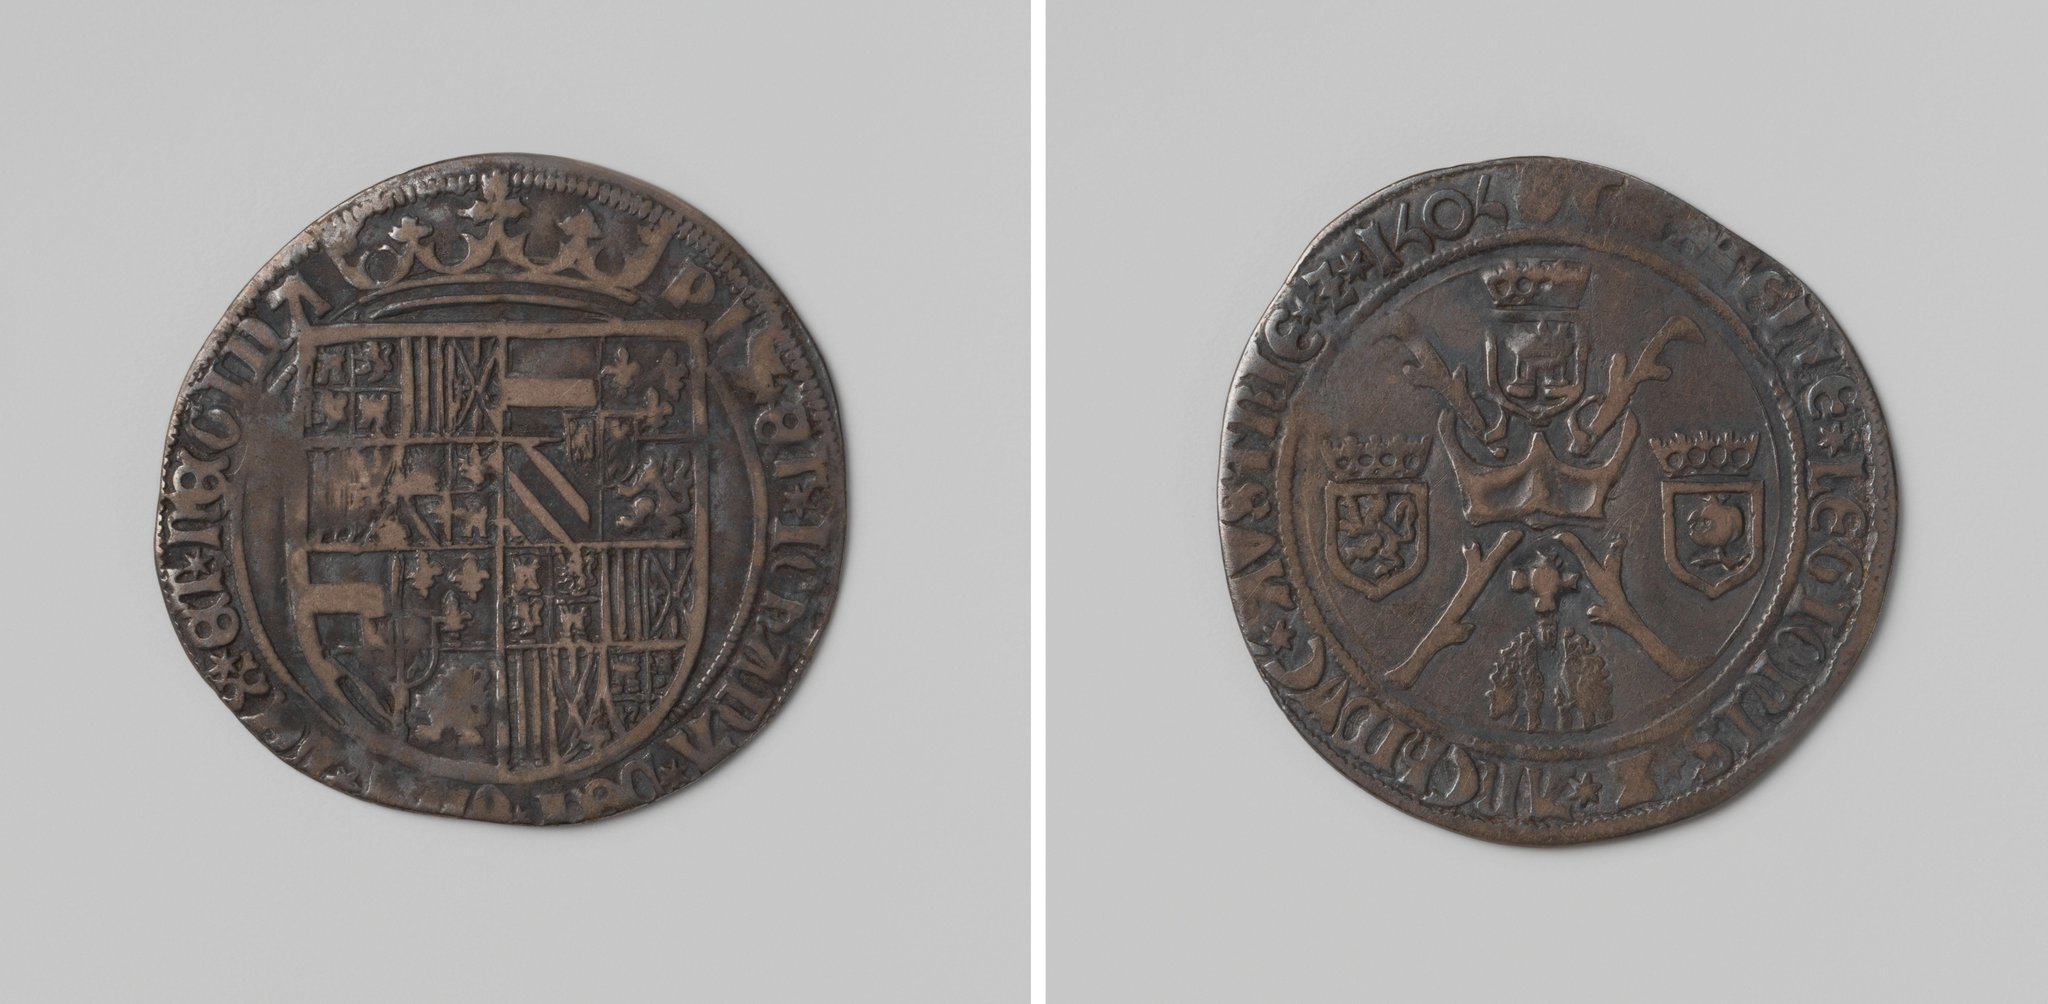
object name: jeton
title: Filips de Schone en Johanna, koningen van Leon en Castilie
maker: Anonymous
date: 1504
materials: copper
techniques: striking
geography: antwerp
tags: bruges, filips de schone (hertog van bourgondië)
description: Koperen penning. Voorzijde: gekroond wapenschild binnen omschrift. Keerzijde: vuurslag, waaraan Gulden Vlies hangt, op Bourgondisch kruis; daarboven, en aan weerszijden: gekroond wapenschild binnen omschrift